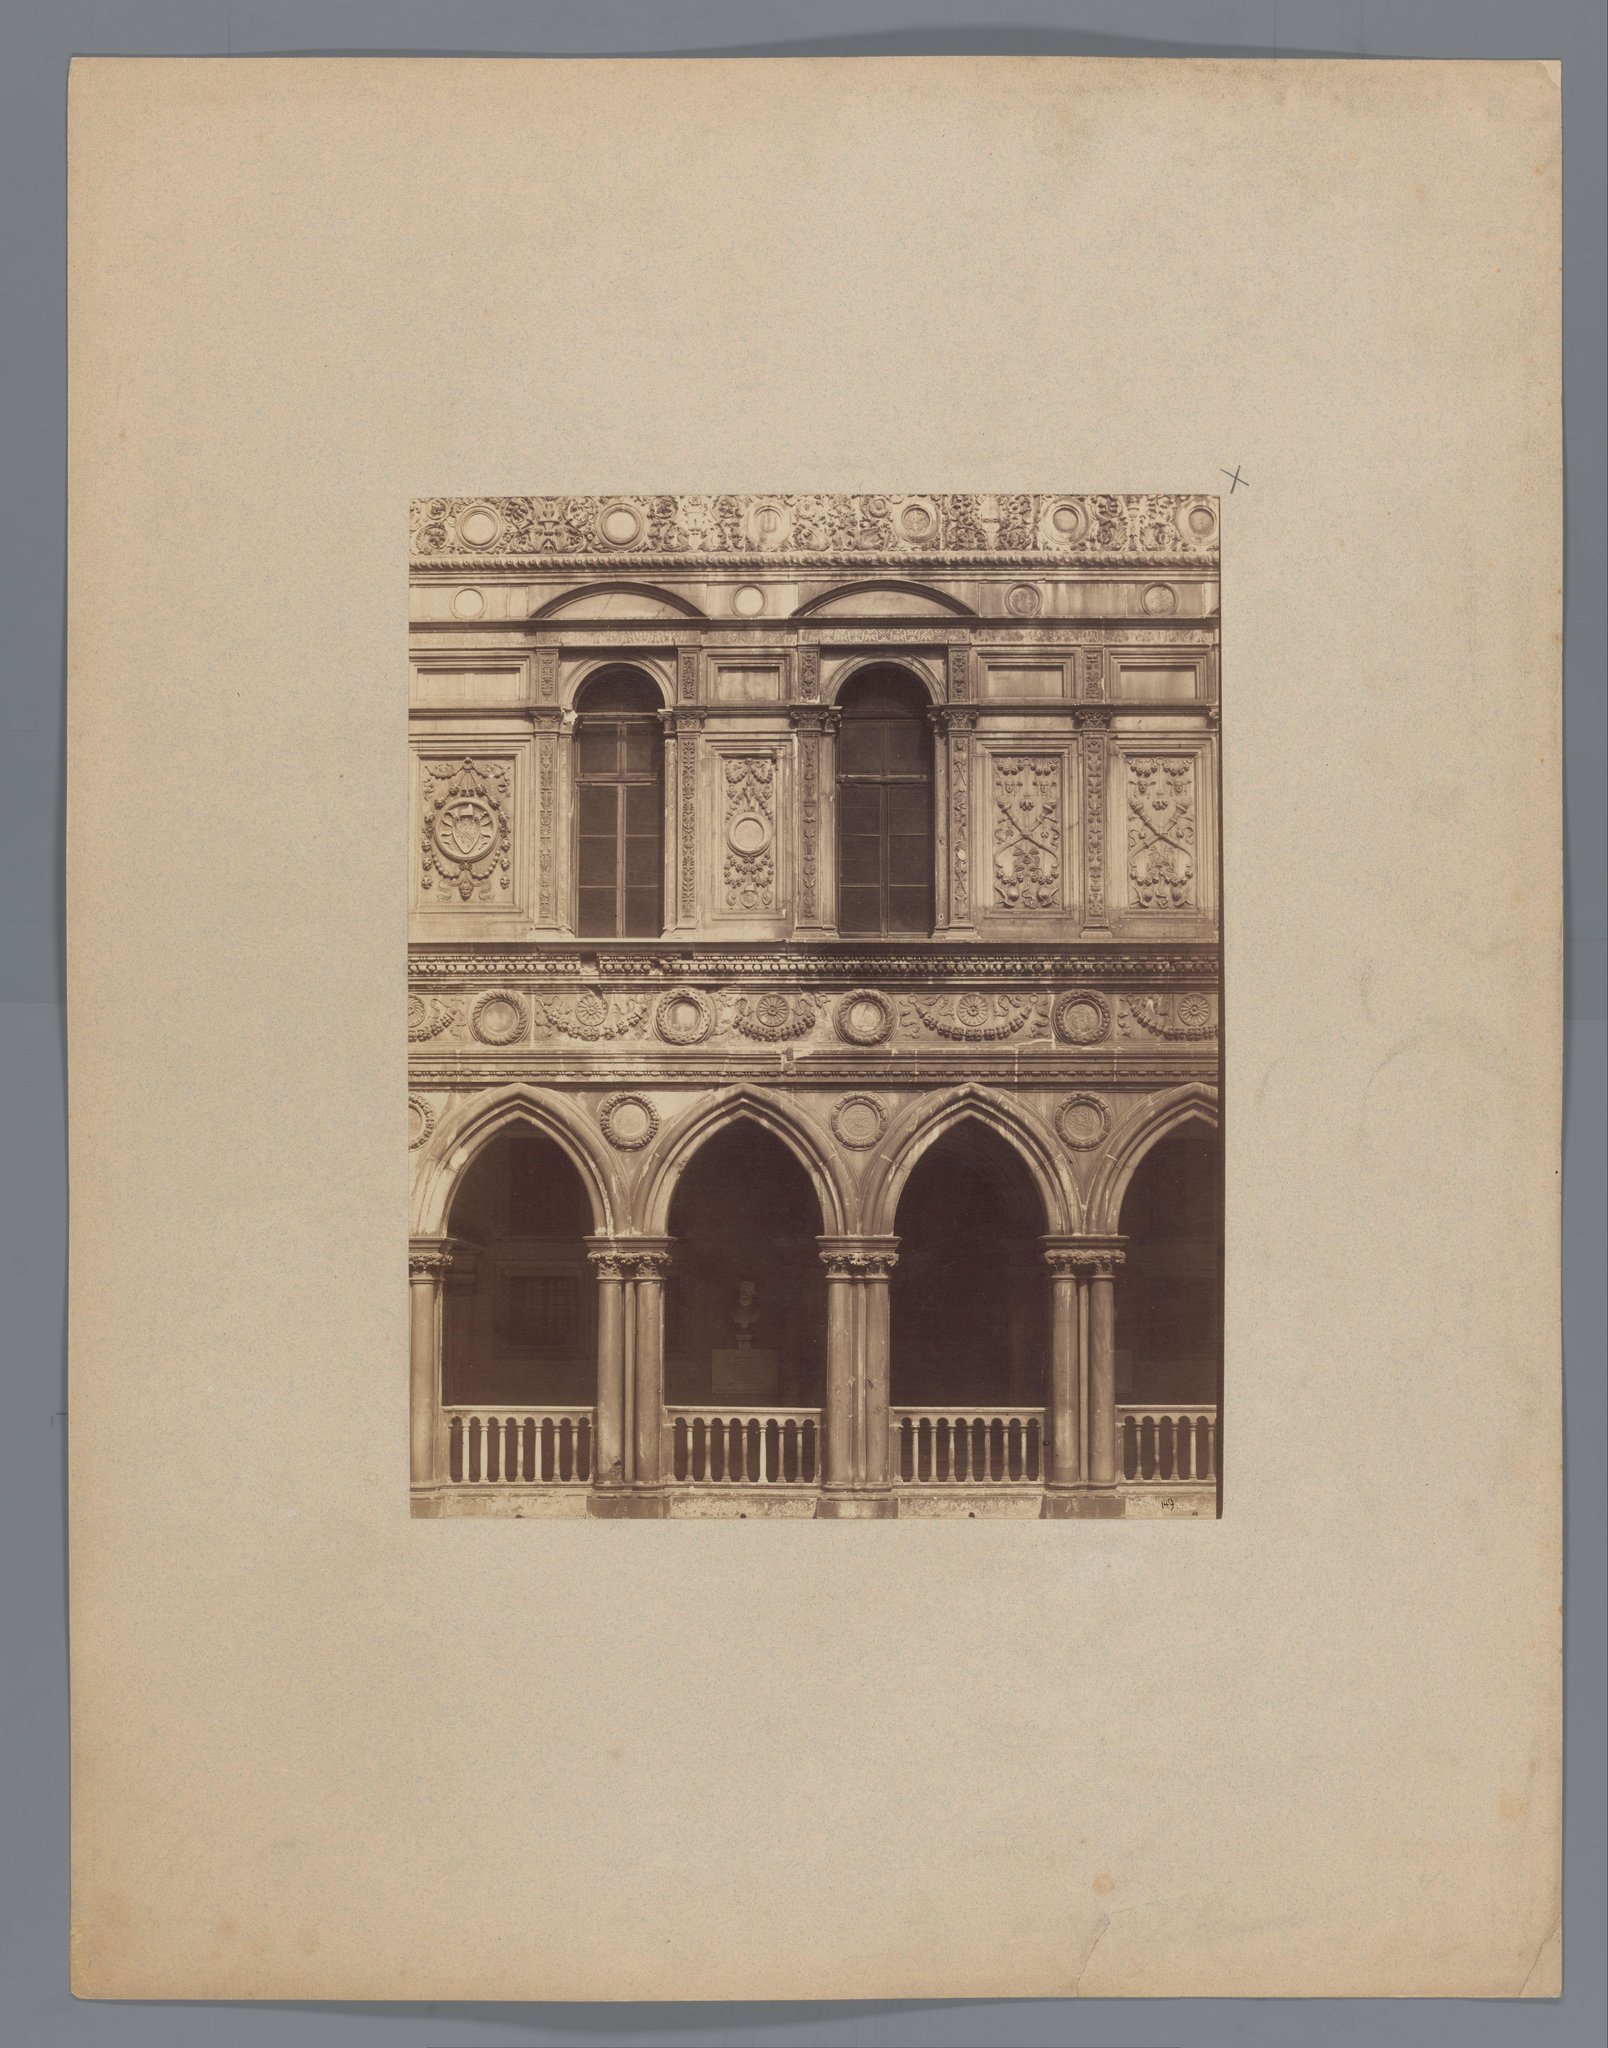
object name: photograph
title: Renaissancistische Italiaanse gevel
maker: carlo naya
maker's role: fotograaf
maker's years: 1816-1882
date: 1880-1900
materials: cardboard, paper, photographic support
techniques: albumen print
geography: italy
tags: italy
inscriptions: : ‘149.’